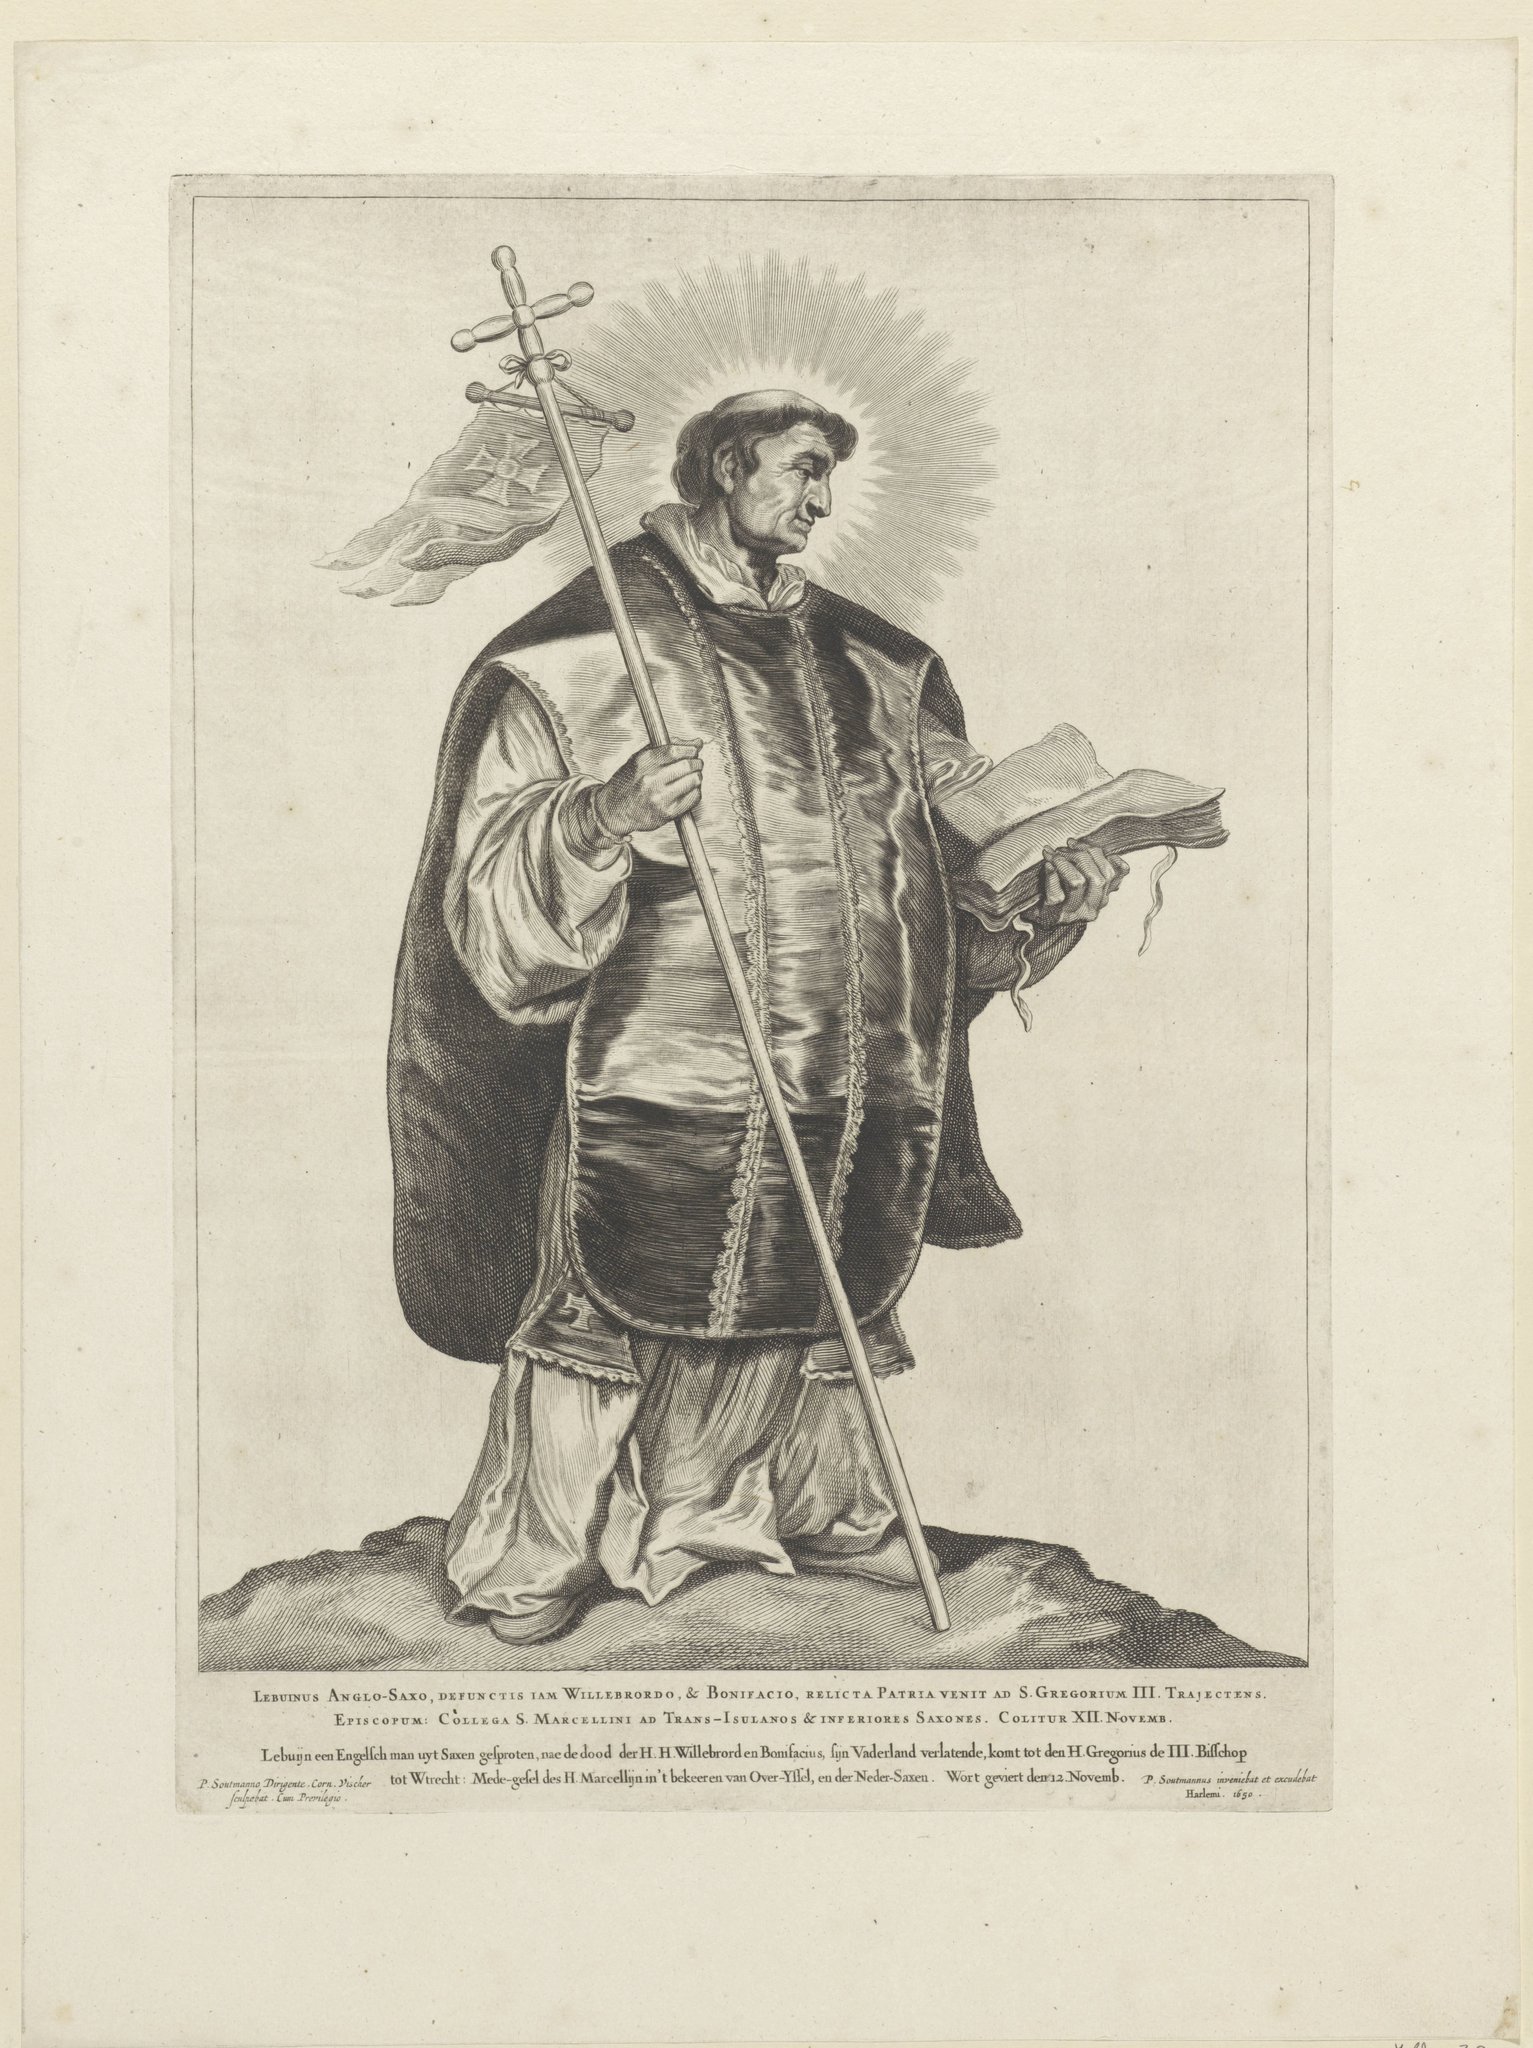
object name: print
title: Nederlandse heiligen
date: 1650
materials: paper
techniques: engraving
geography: haarlem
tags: heilige, lebuinus van deventer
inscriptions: collector's mark: Lugt 240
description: Deze prent maakt deel uit van de serie: Iesv Christo, Fideli Militantis Ecclesiae Imperatori, Liberali Eivsdem, Trivmphantis, Remvneratori, hos In Foederato Belgio Militiae Svae Legatos, Sanctissimos Sacri Belli Dvces, Patriae Apostolos, Et Decora Lvmina, Cvm Dvabvs Heroinis, Militans In Iisdem Provinciis Ecclesia. Haarlem: Pieter Claesz. Soutman, 1650.